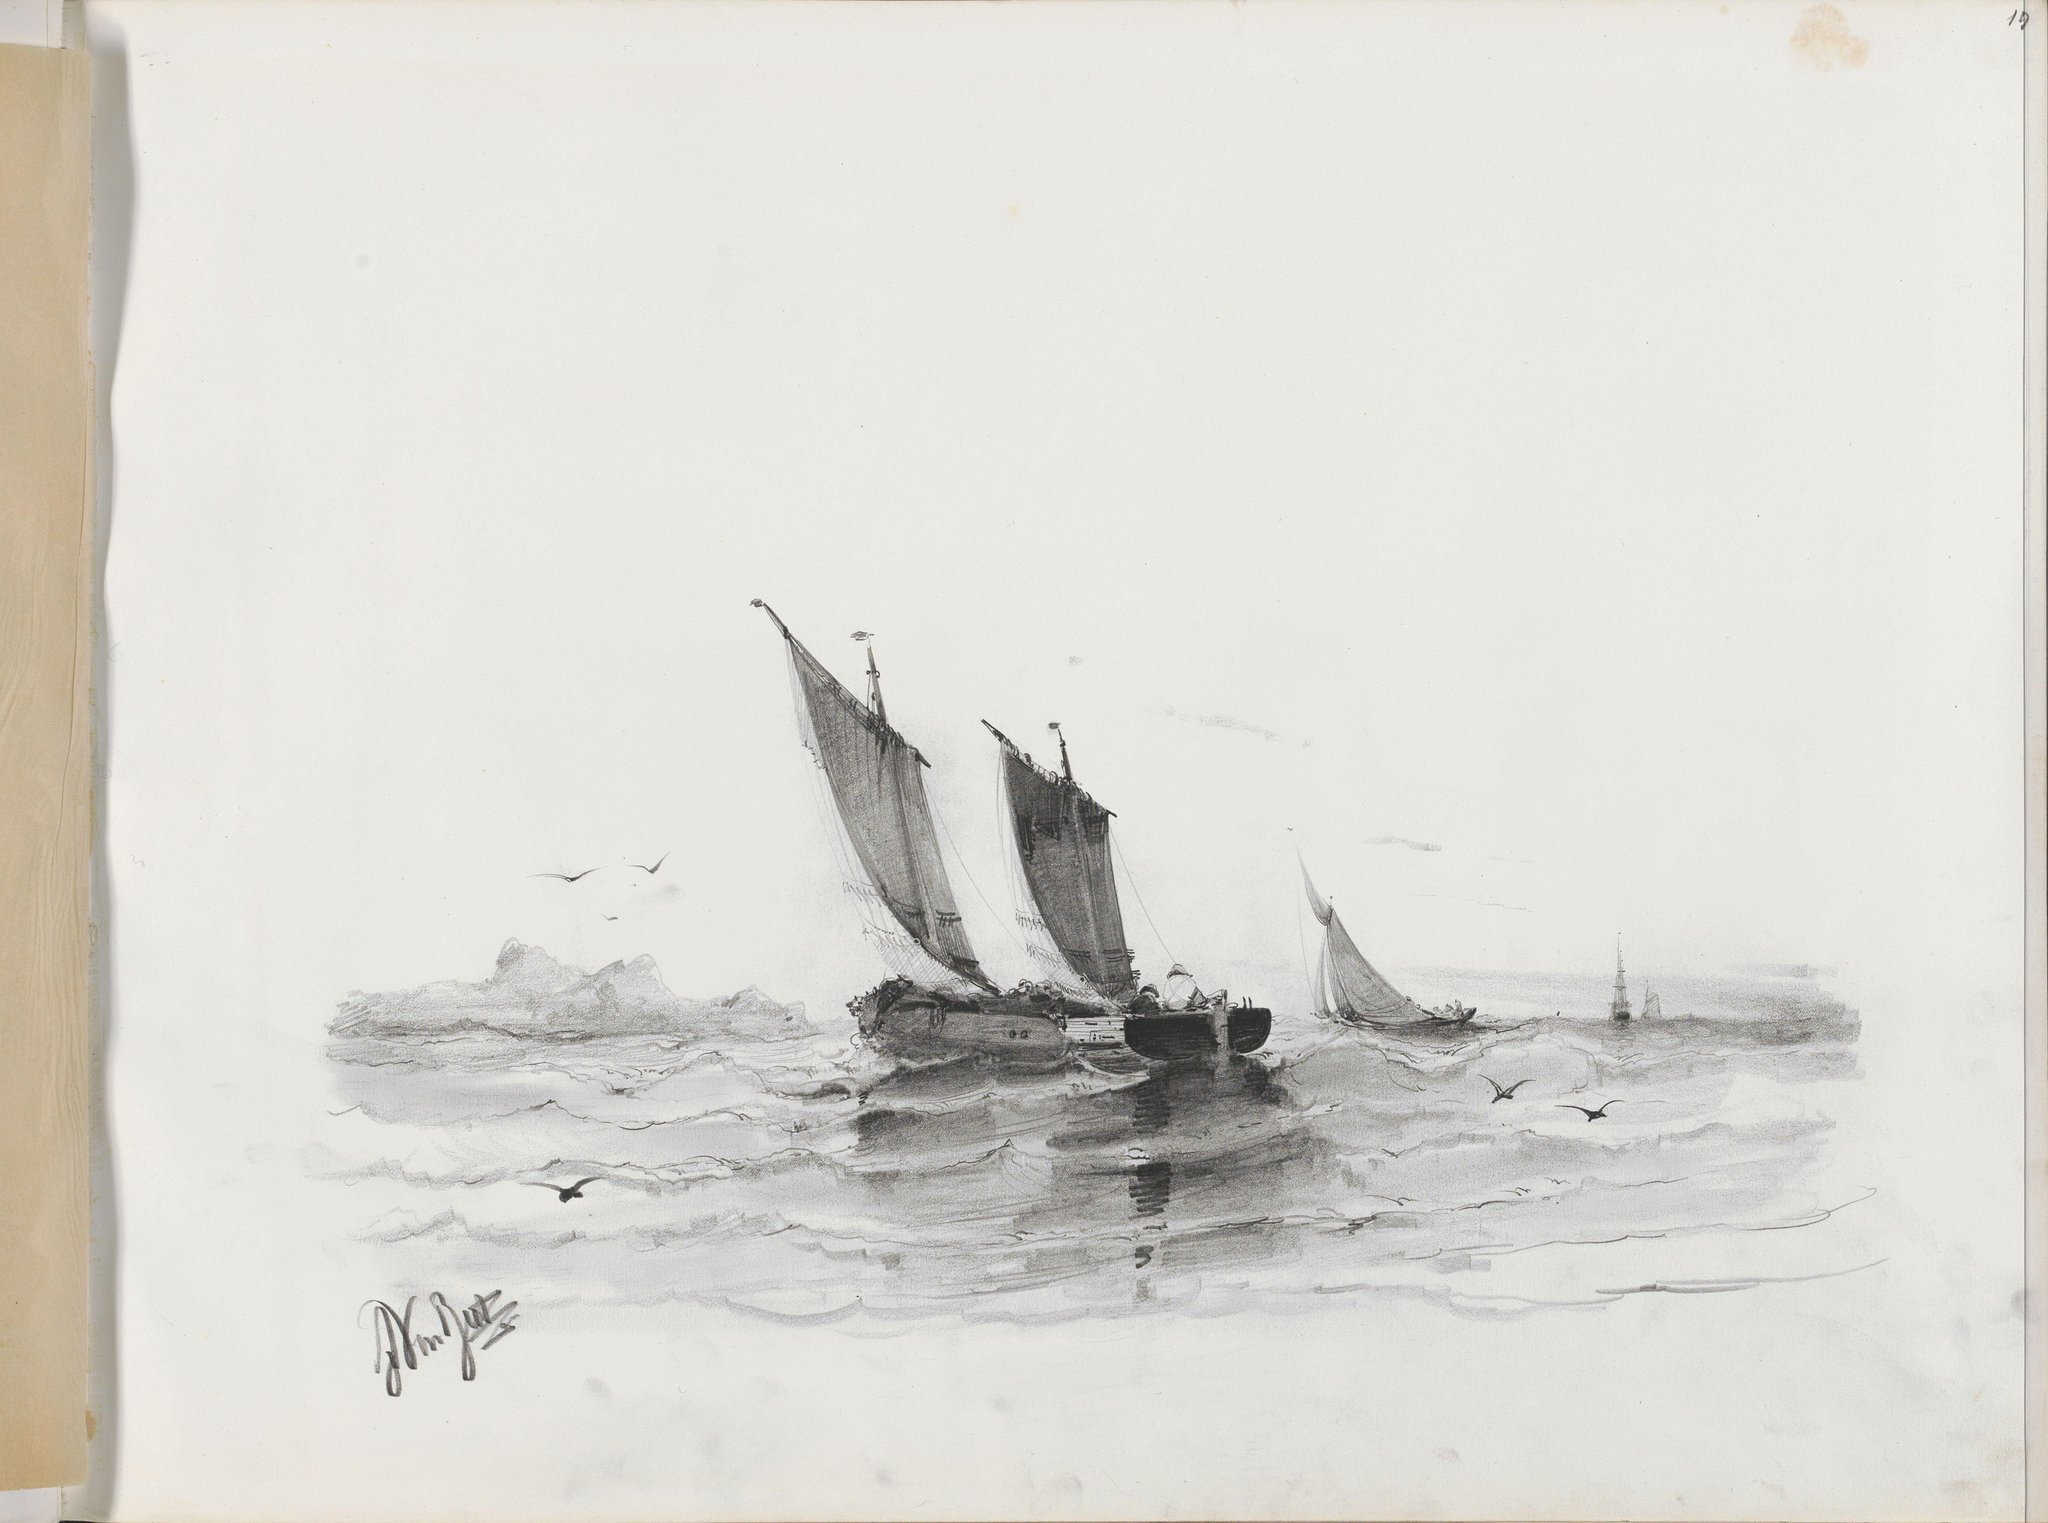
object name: sketchbook leaf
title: Vissersboten op het water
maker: albertus van beest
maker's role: draughtsman, print maker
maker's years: 1820-1860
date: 1830-1860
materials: paper, pencil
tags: sailing-ship, sailing-boat, landscapes with waters, waterscapes, seascapes (in the temperate zone)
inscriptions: signature: ‘AVan Beest’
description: Blad 19 recto uit een schetsboek met 46 bladen.